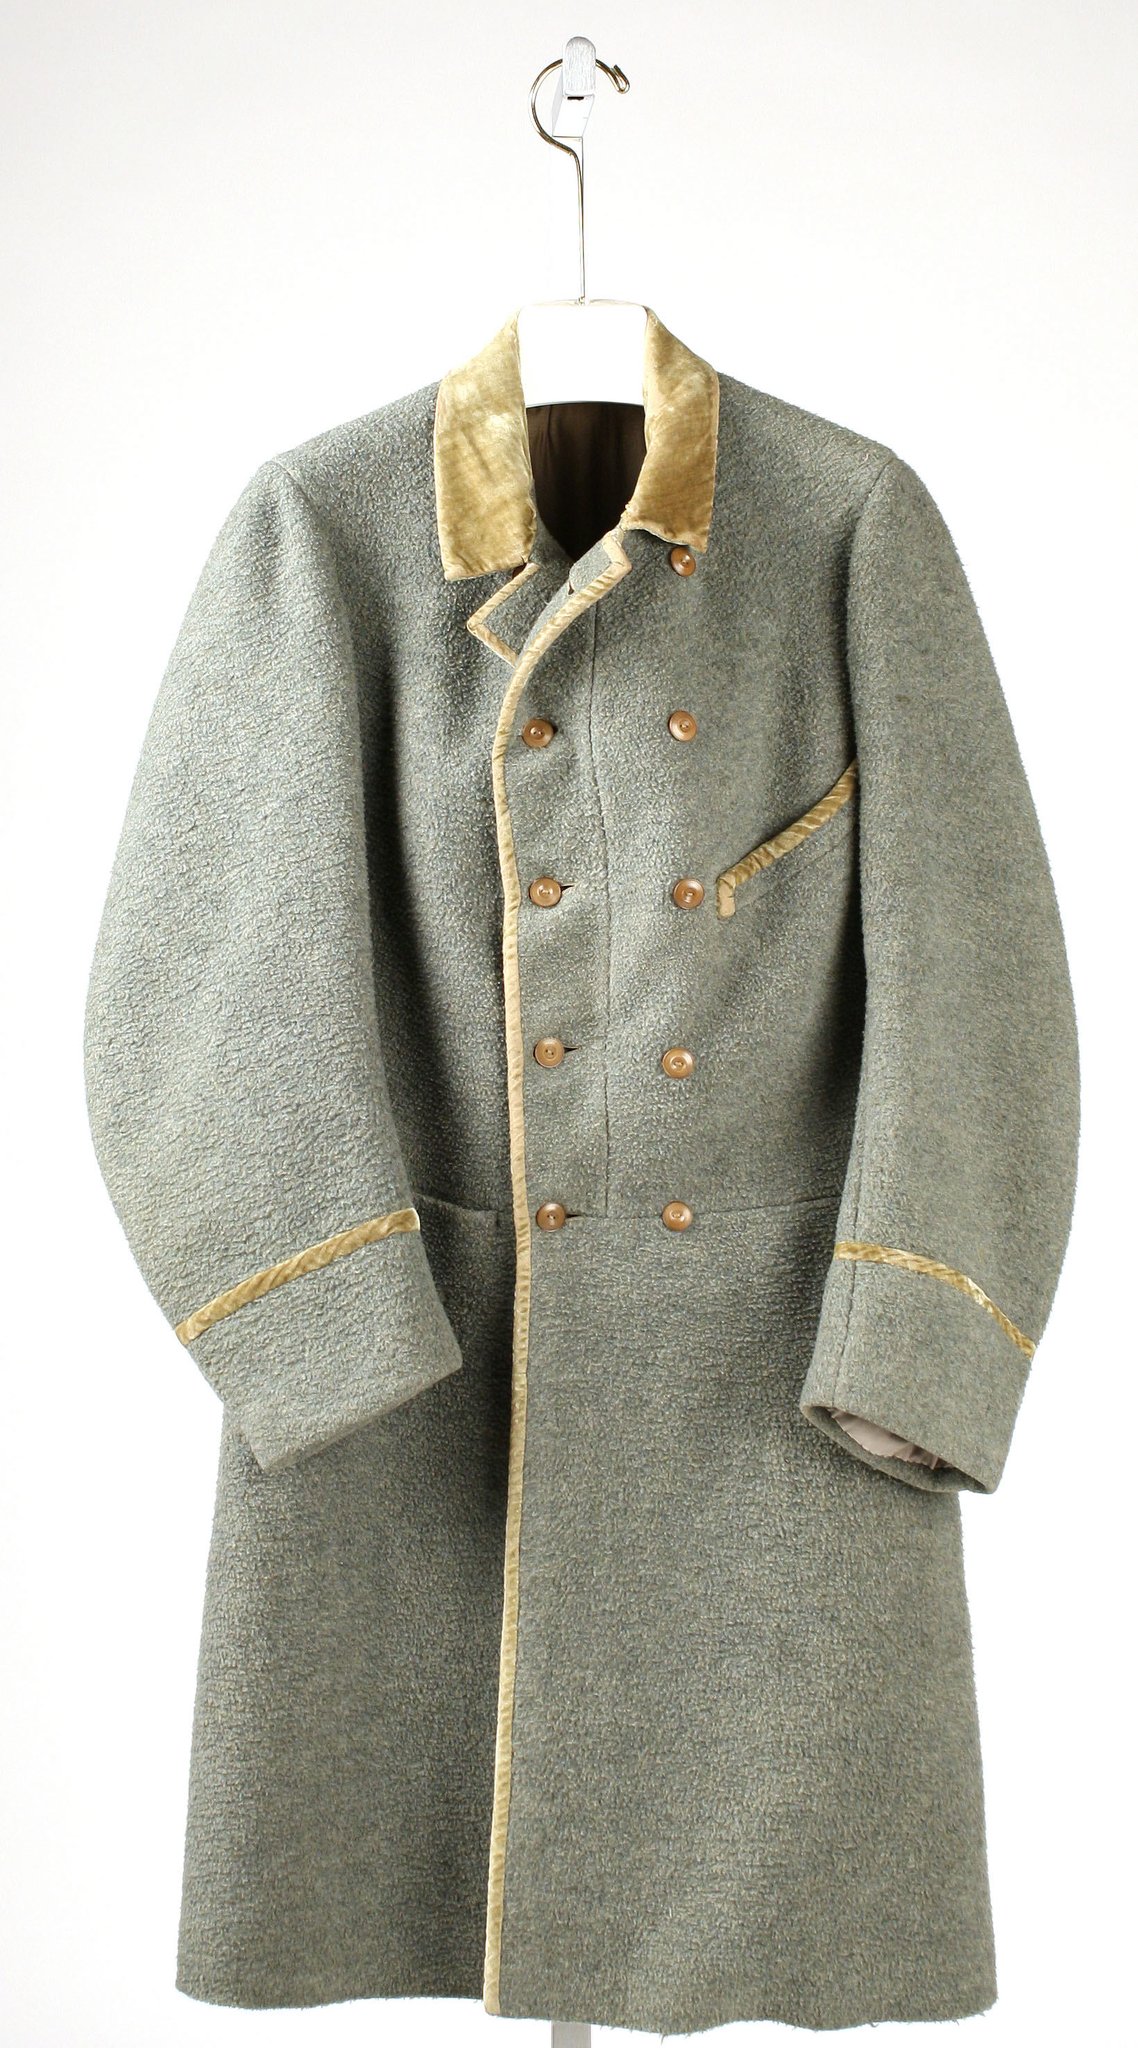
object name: overcoat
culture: british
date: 1845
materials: fur, wool